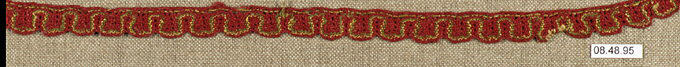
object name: edging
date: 1801-1900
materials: silk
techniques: lace